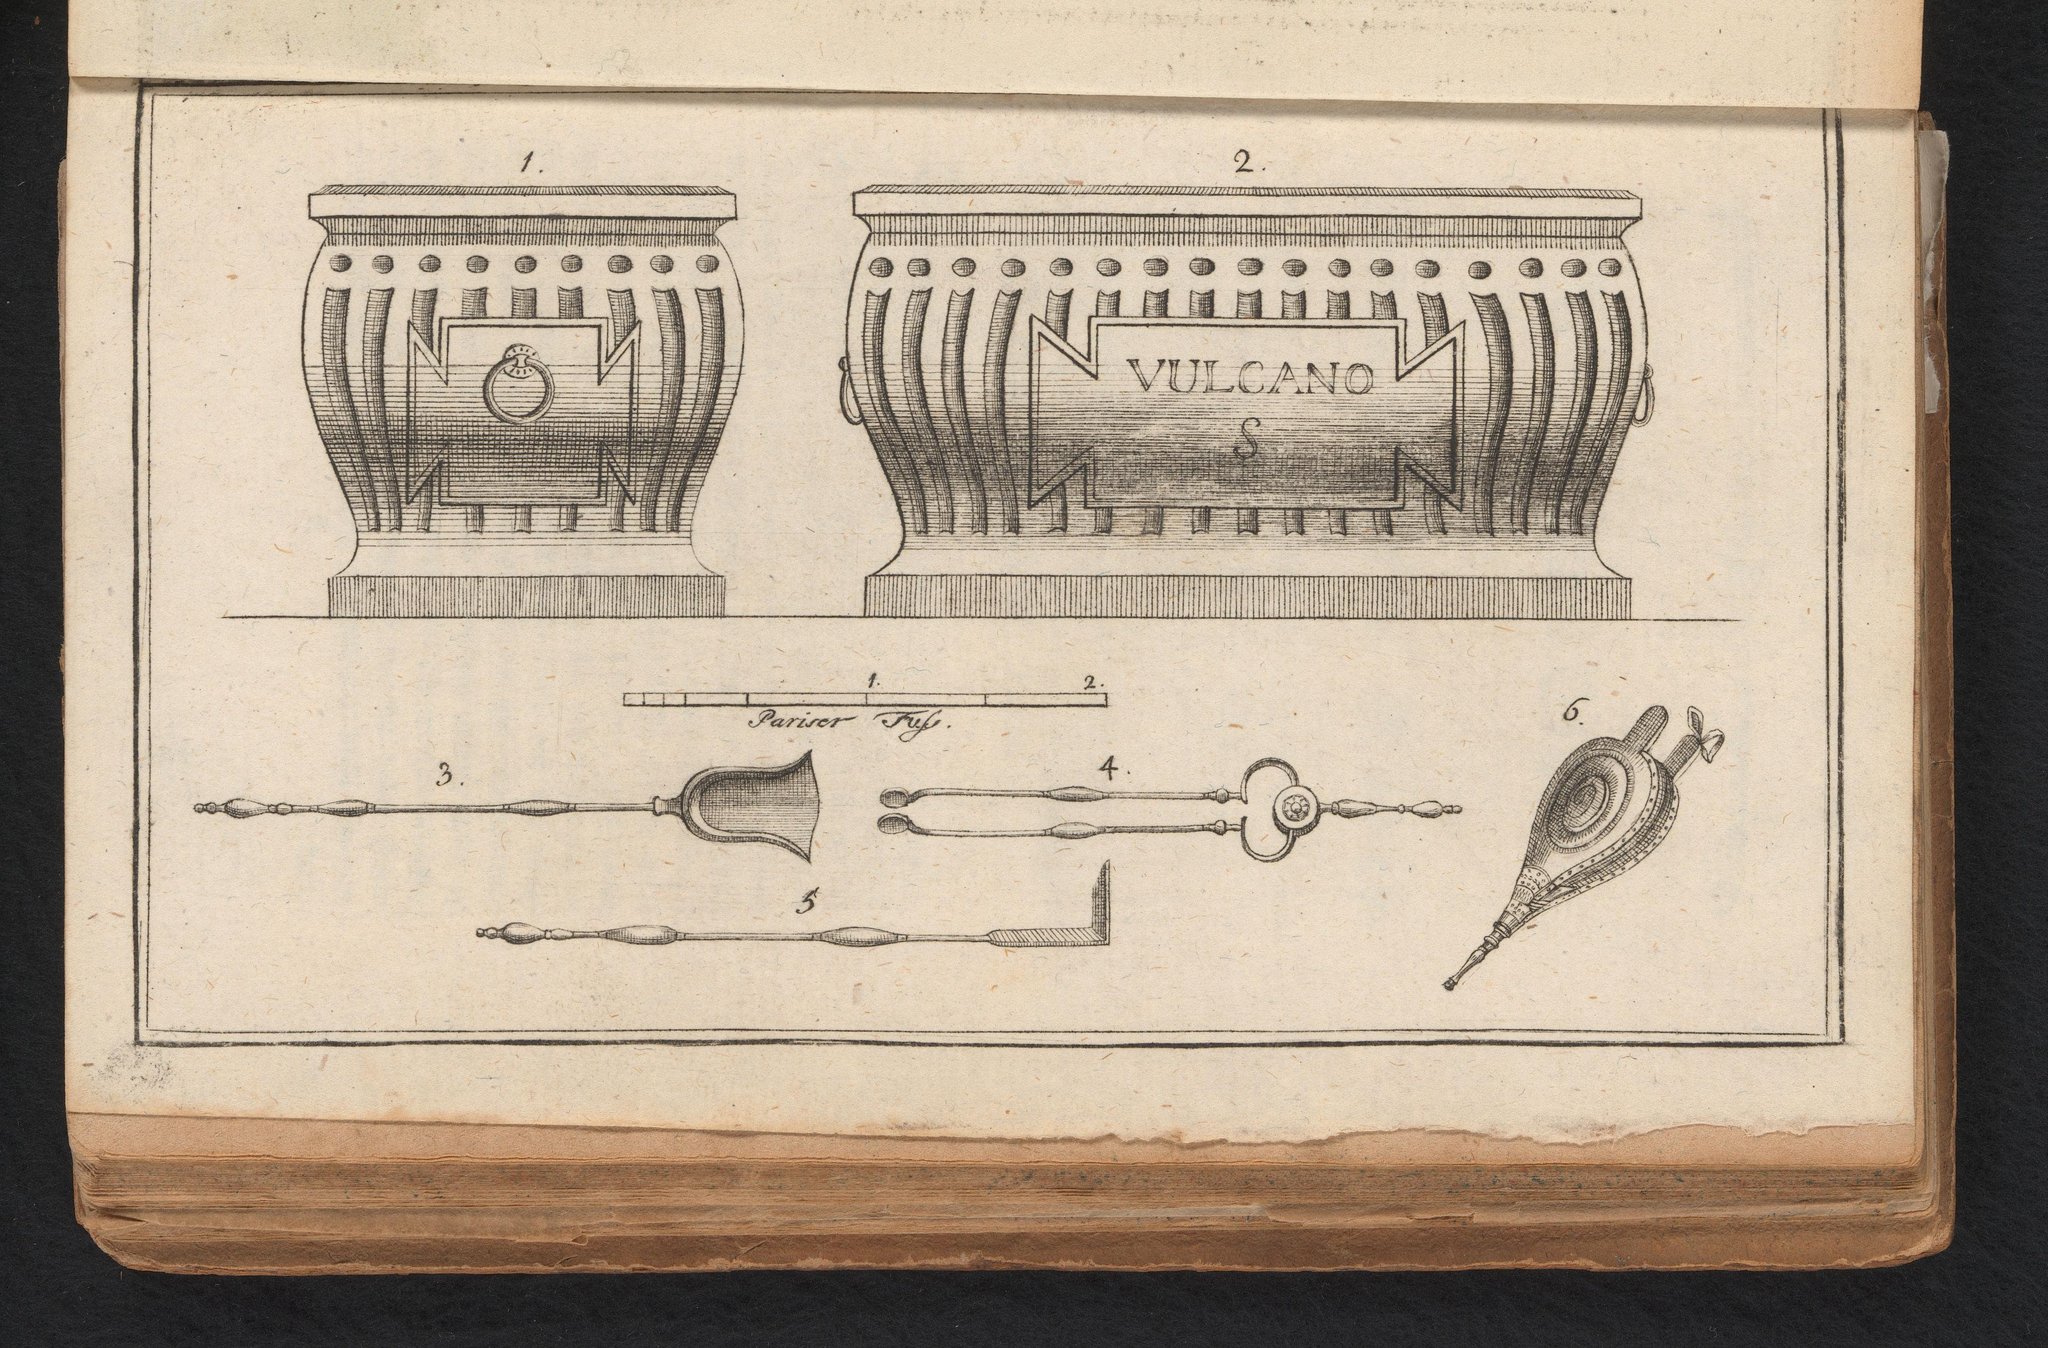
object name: fashion print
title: Journal des Luxus und der Moden 1786, Band I, T. 34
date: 1786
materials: paper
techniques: etching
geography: weimar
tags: fashion plates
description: Houten kist voor in de kamer, in de vorm van een antieke sarcofaag. Prent uit het modetijdschrift Journal des Luxus und der Moden, uitgegeven door Friedrich Justin Bertuch en Georg Melchior Kraus, Weimar, 1786-1826.